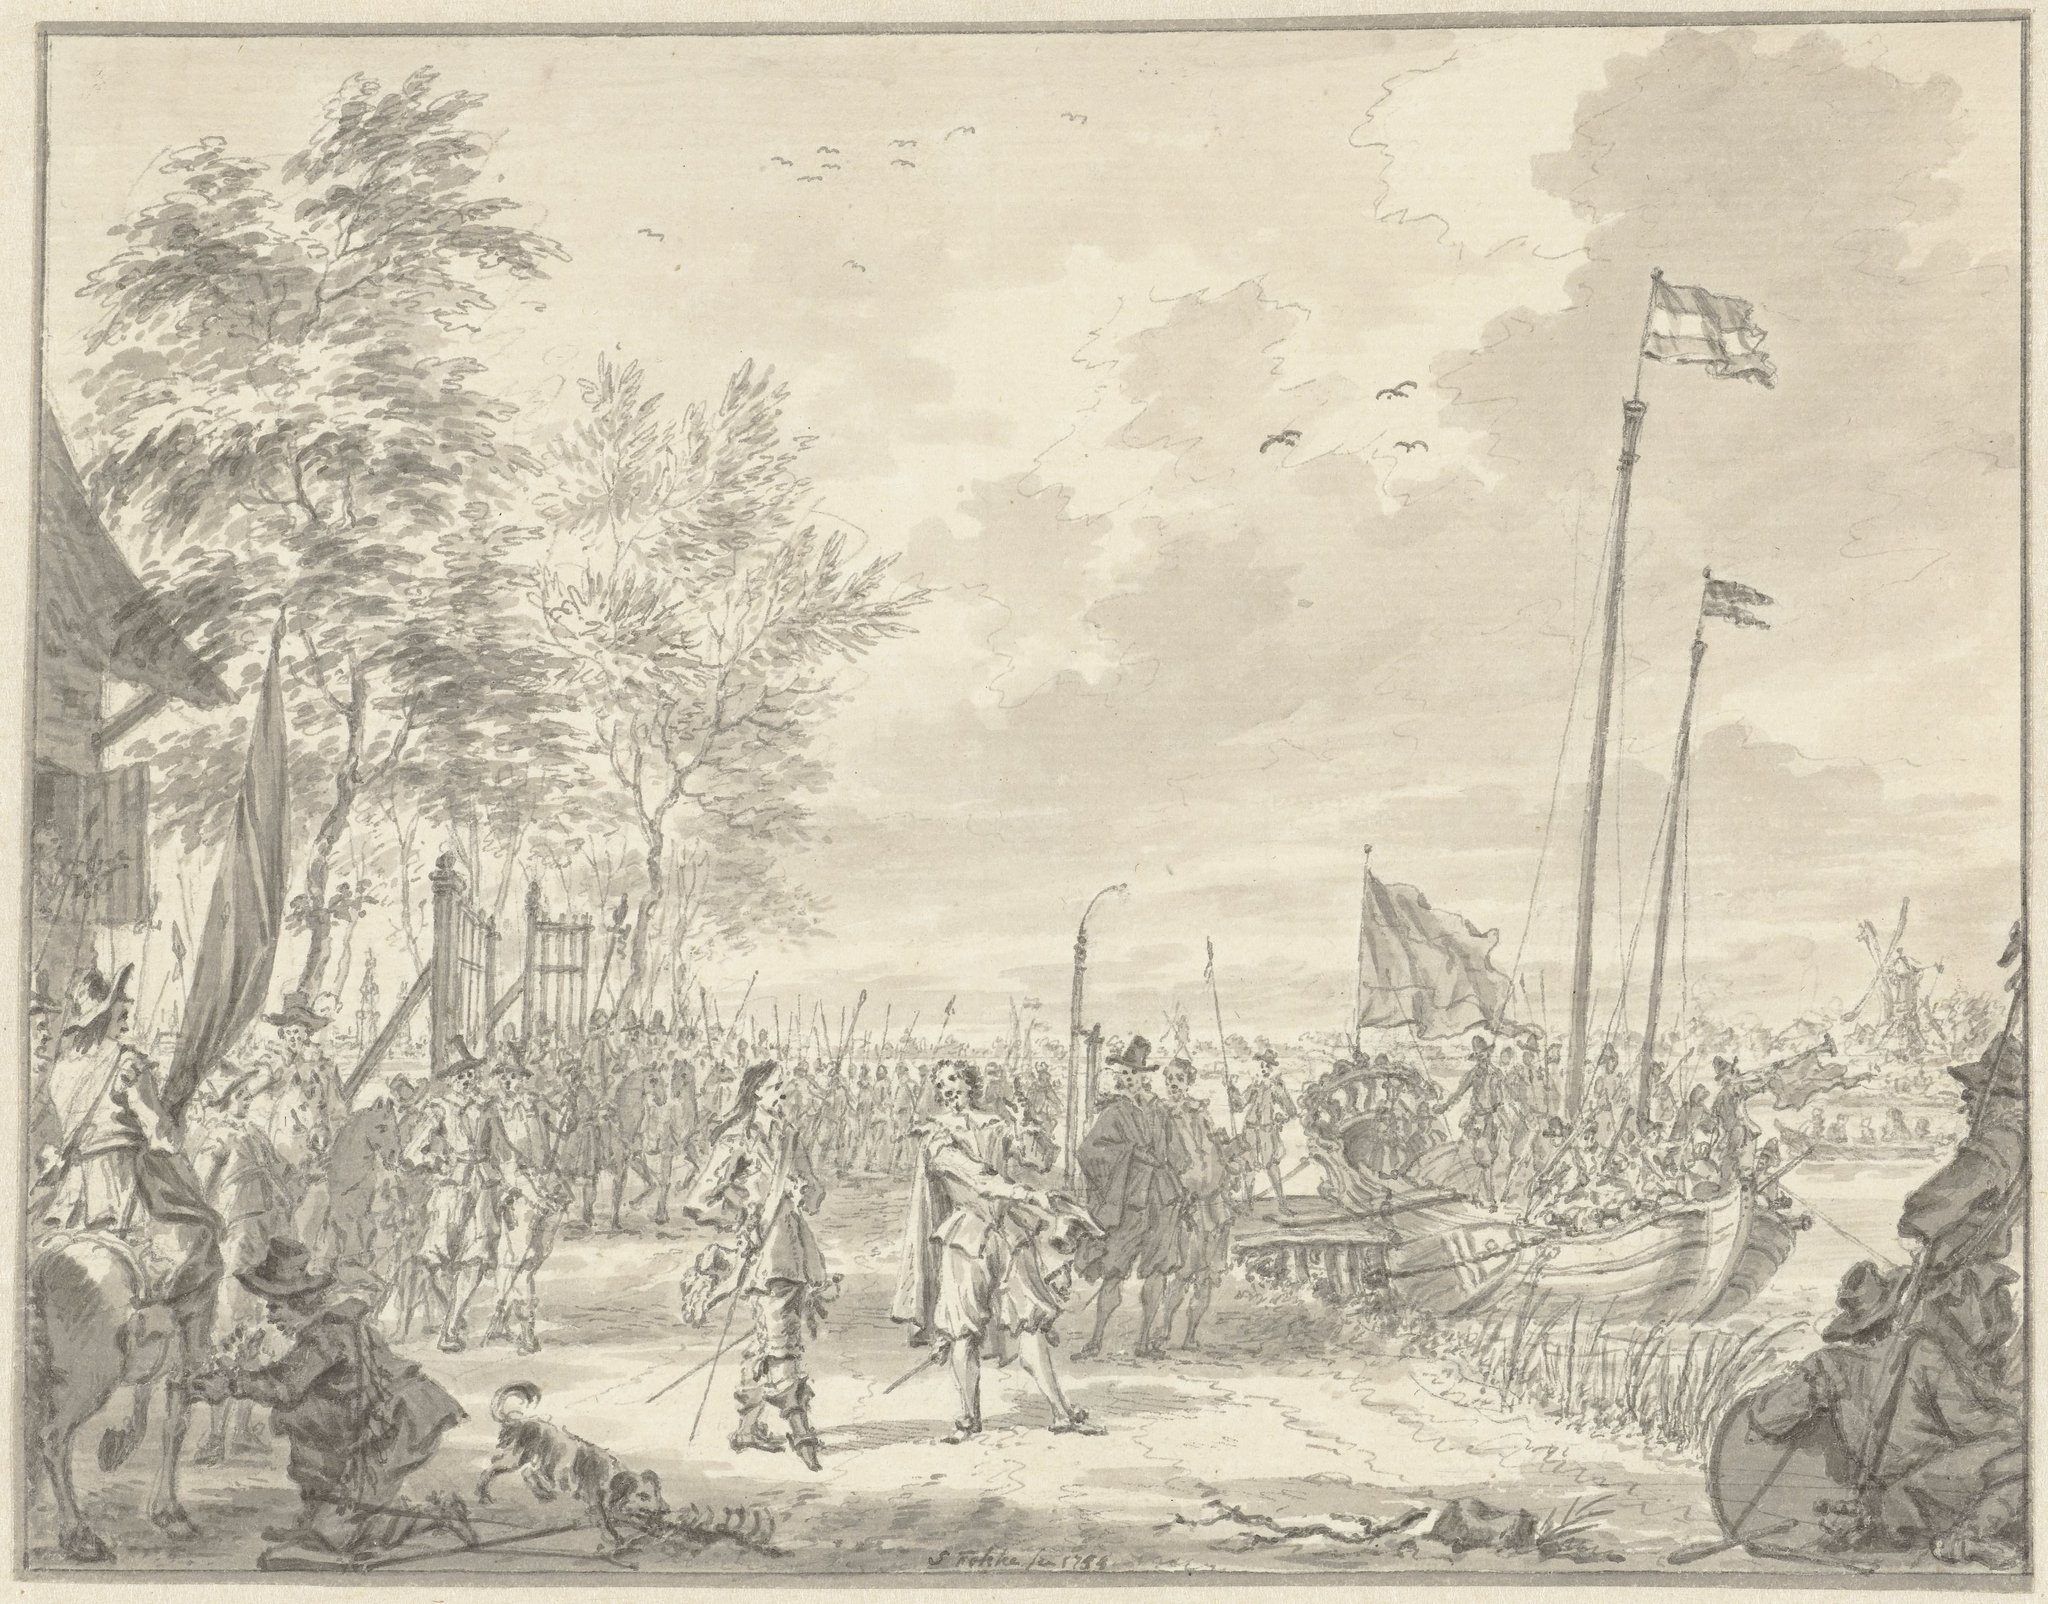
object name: historieplaat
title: Onderhandeling tussen afgevaardigden van Amsterdam en graaf Willem Frederik bij Hofstede Welna aan de Amstel, 1650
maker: simon fokke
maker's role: draughtsman, print maker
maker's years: 1712-1784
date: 1754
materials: ink, paper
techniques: brush, pen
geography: northern netherlands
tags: arnhem, william ii (prince of orange), peace negotiations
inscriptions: date: ‘1754’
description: Onderhandeling tussen twee afgevaardigden van de stad Amsterdam en stadhouder Willem Frederik voor Hofstede Welna aan de Amstel, 29-30 juli 1650. Aan de rivieroever het Statenjacht. Ontwerp voor een prent.